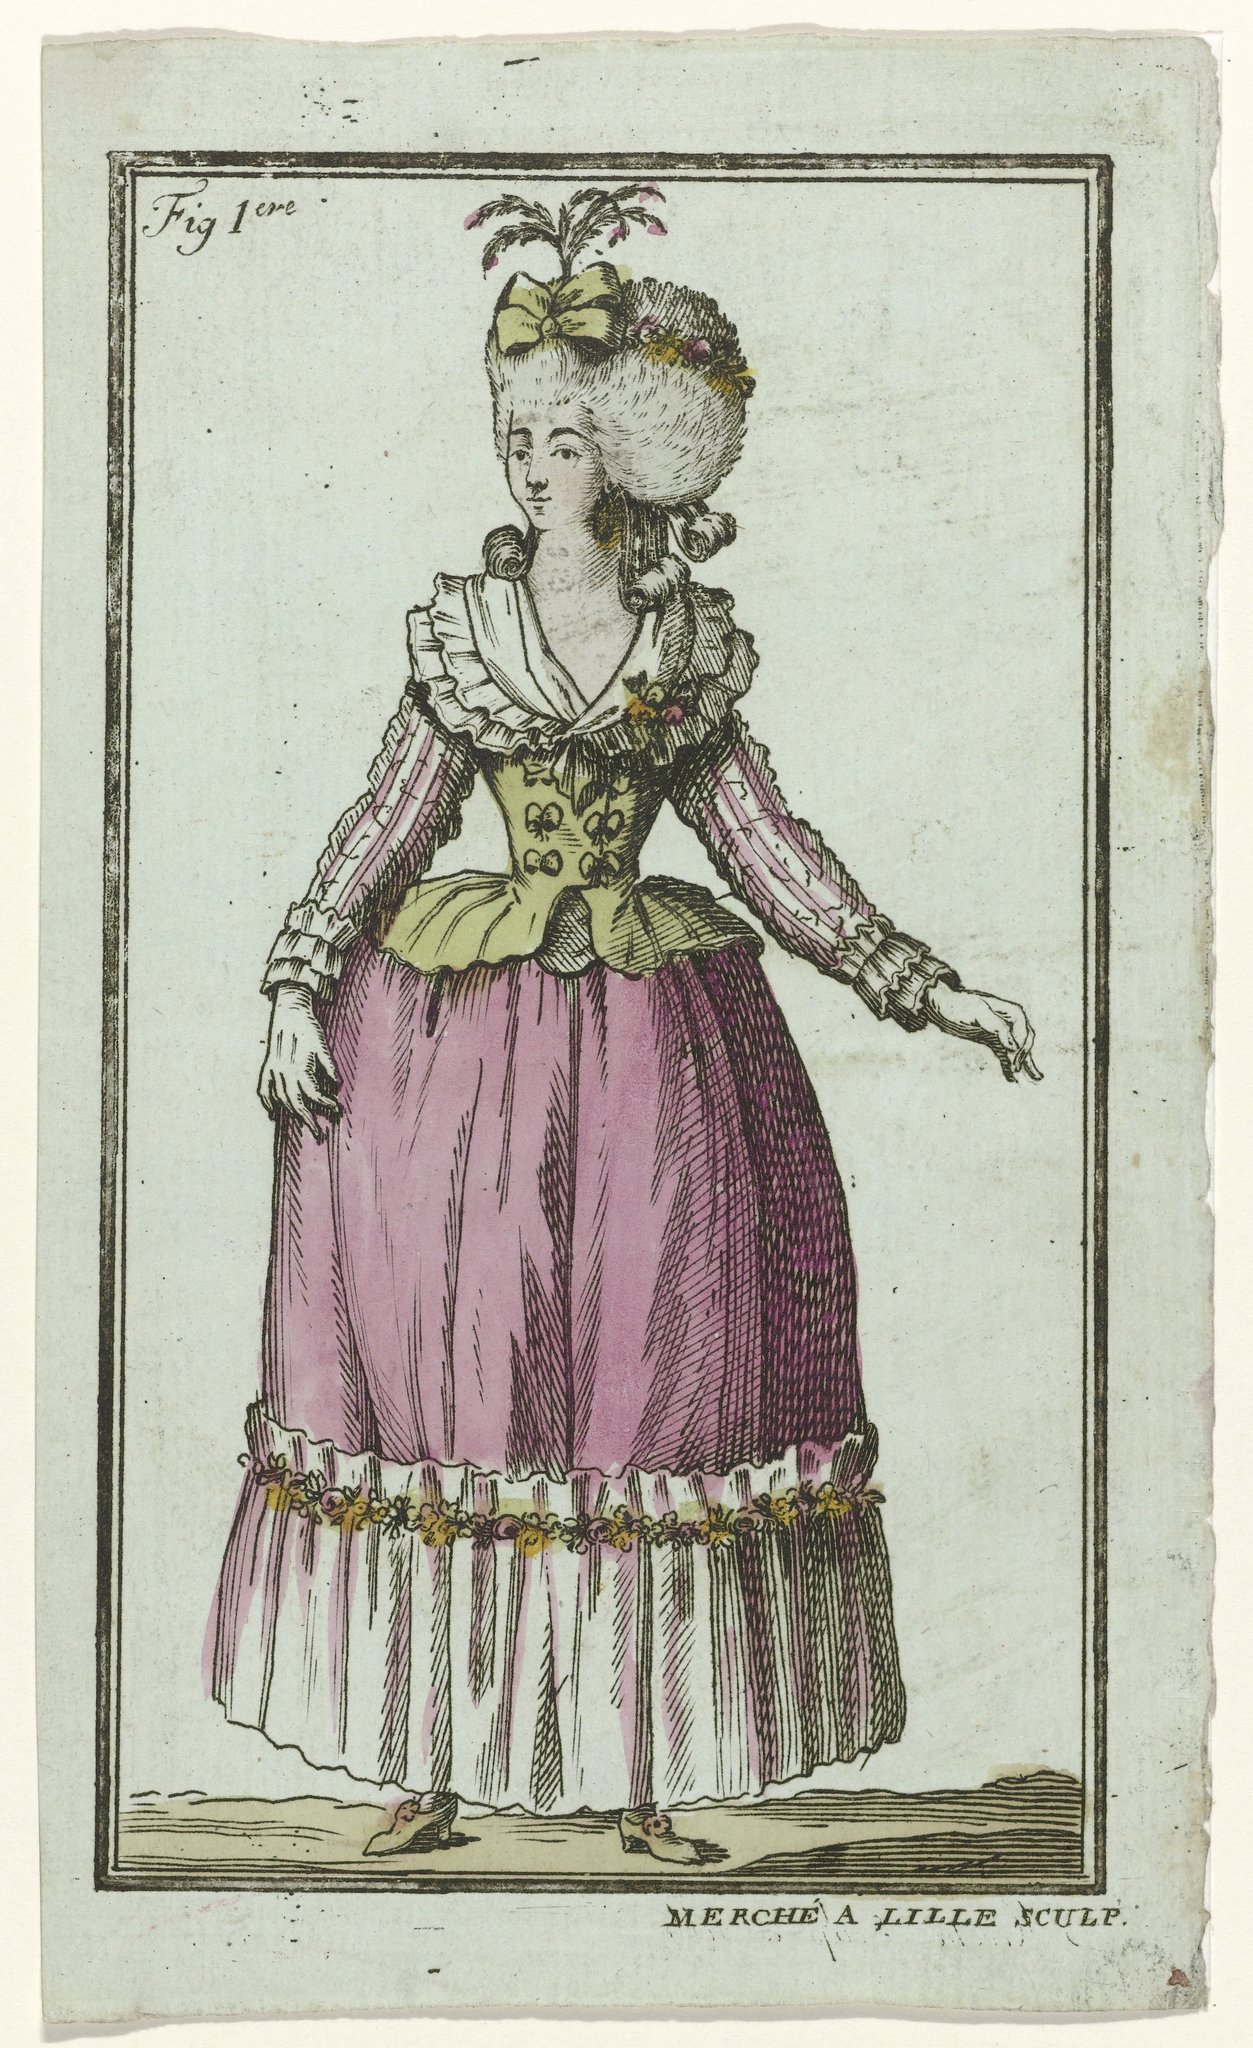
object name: fashion print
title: Magasin des Modes Nouvelles Françaises et Anglaises, kopie naar 10 février 1787, Pl. 1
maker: merché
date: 1787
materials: paper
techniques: engraving, hand coloring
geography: lille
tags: corsage (+ women's clothes), clothing for the upper part of the body (caraco) (+ women's clothes), ear-rings (+ women's clothes), styles of hairdress - aa - ~ women, fashion plates, shoes, sandals (+ women's clothes), skirt (+ women's clothes), gloves, mittens, etc. (+ women's clothes), piece of clothing covering the breast or décolleté (fichu) (+ women's clothes)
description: Staande vrouw gekleed in een caraco van satijn en een rok afgezet met een gerimpelde strook stof, versierd met bloemen. Fichu. Het opgekapte haar is versierd met veren, een strik en een krans van bloemen. Accessoires: oorbellen, bloemcorsage, handschoenen, schoenen met hakken en rozetten(?). De prent is een kopie door uitgever Merché in Lille, naar het 9e Cahier, 2e année, uit de serie Magasin des Modes Nouvelles Françaises et Anglaises . De serie bestaat uit 172 modeprenten, uitgegeven door Buisson, Parijs, 20 novembre 1786 - 21 décembre 1789.